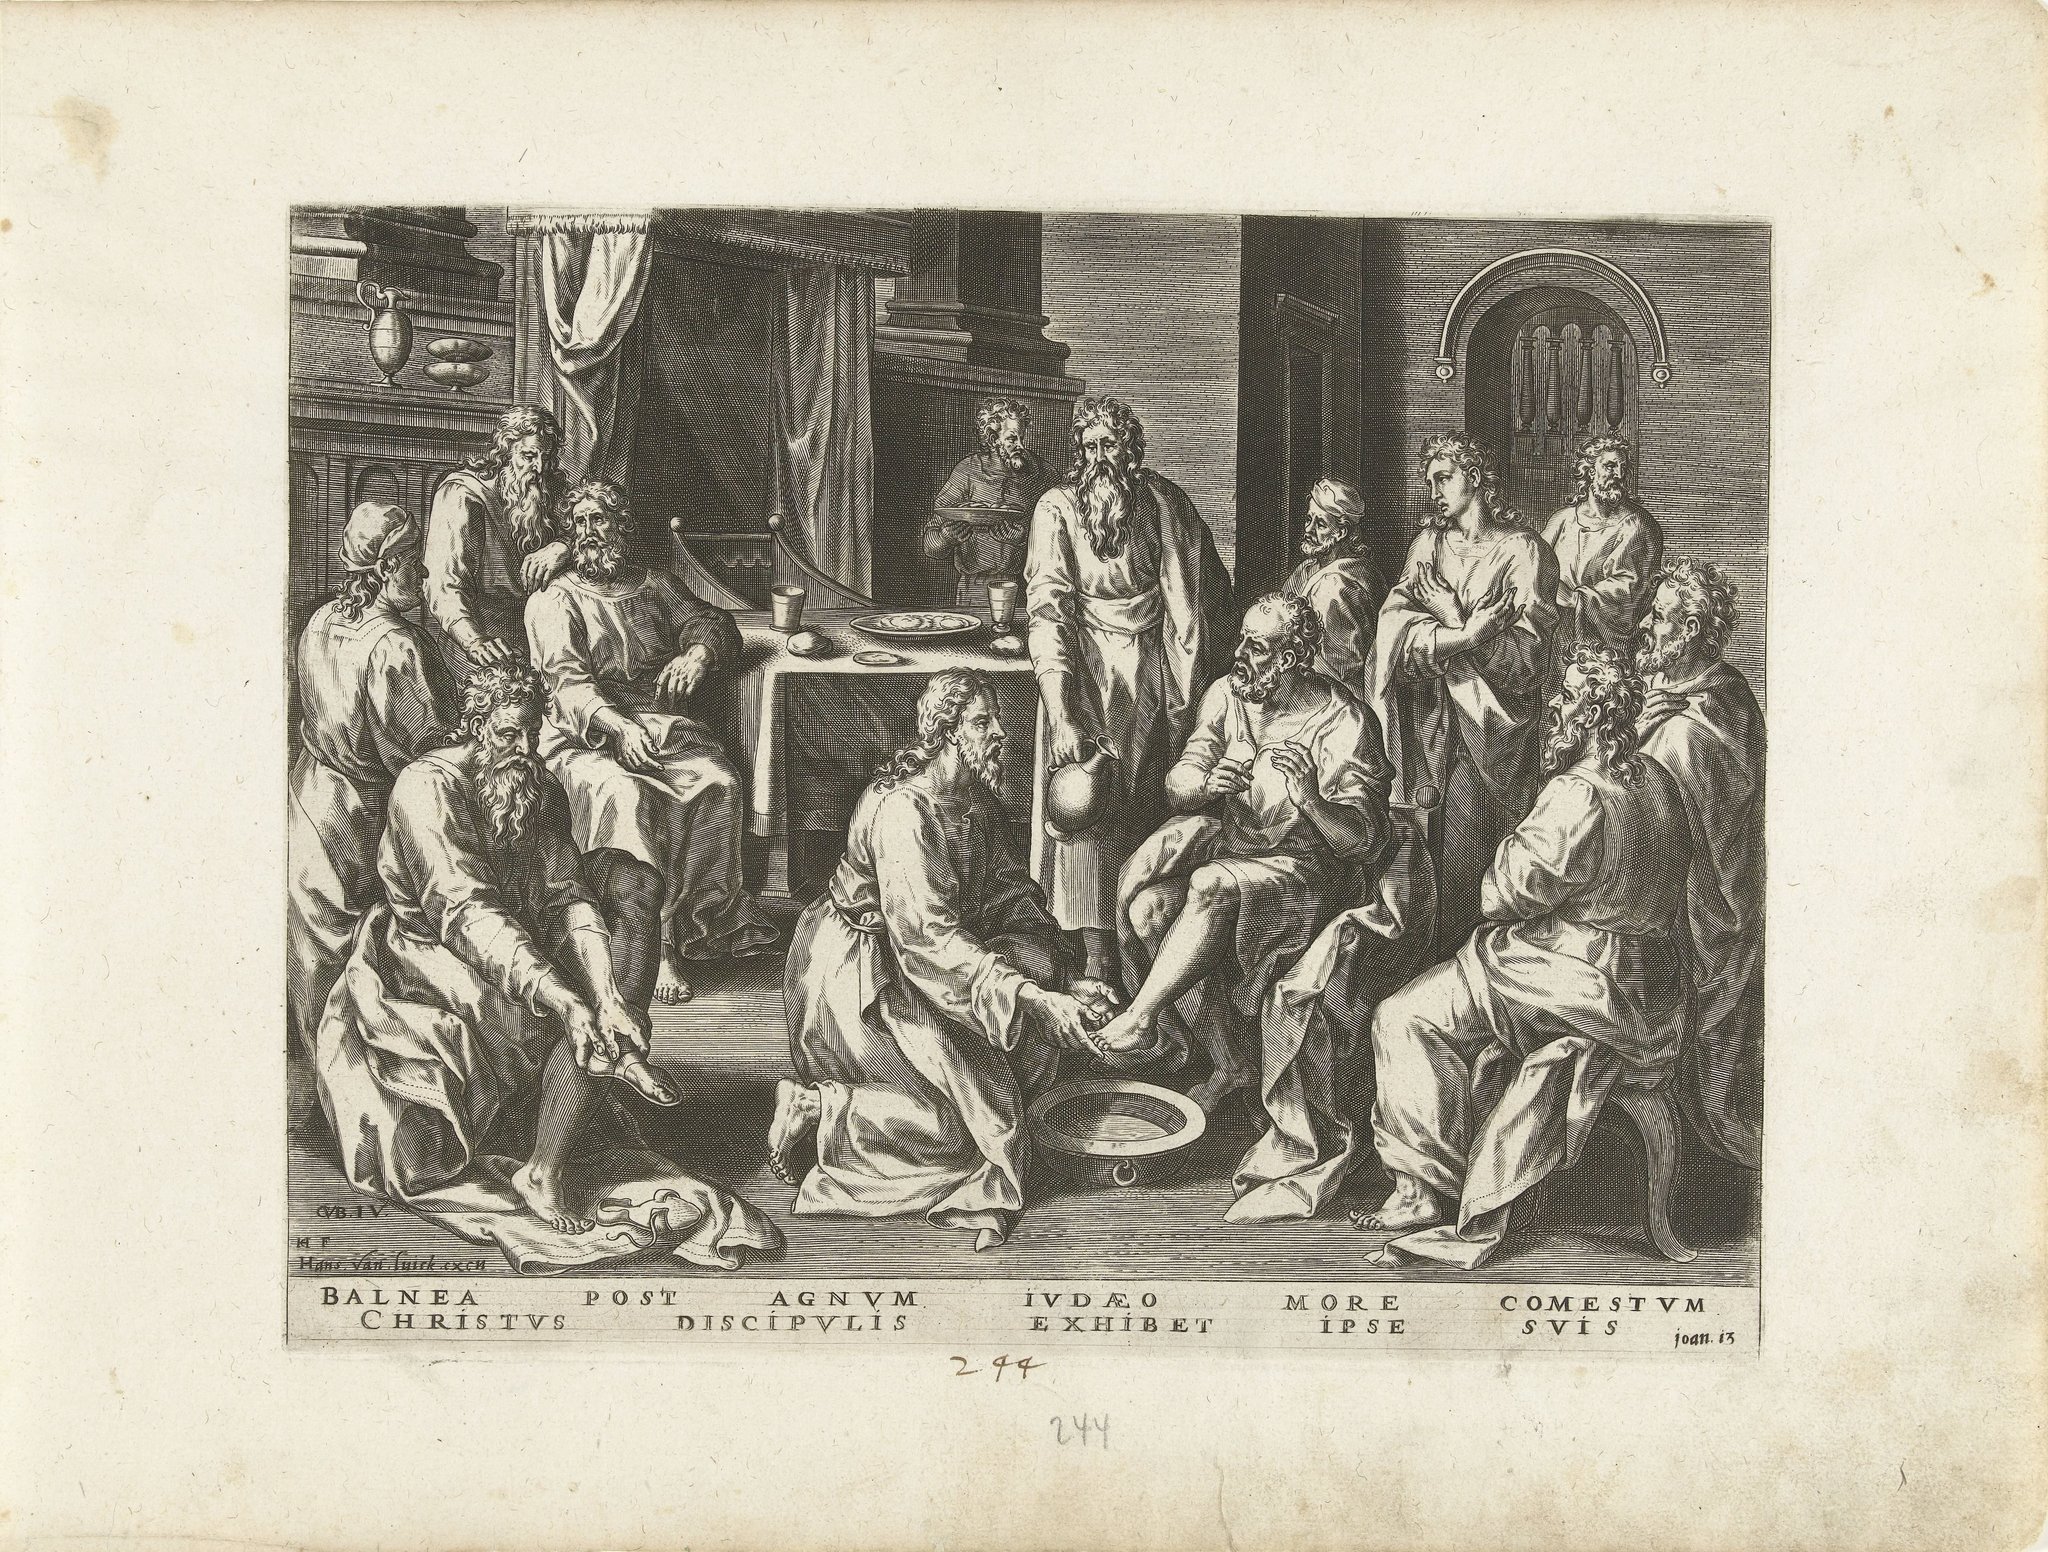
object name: print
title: Voetwassing van Petrus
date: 1534-1580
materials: paper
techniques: engraving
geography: antwerp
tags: christ washes peter's feet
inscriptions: collector's mark: Lugt 2760, collector's mark: Lugt 2228, number: ‘244’, number: ‘1’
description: Christus zit geknield voor Petrus en wast zijn voeten. Petrus protesteert. De andere apostelen staan en zitten blootsvoets rondom het tweetal (Johannes 13:4-17). De prent heeft een Latijns onderschrift.